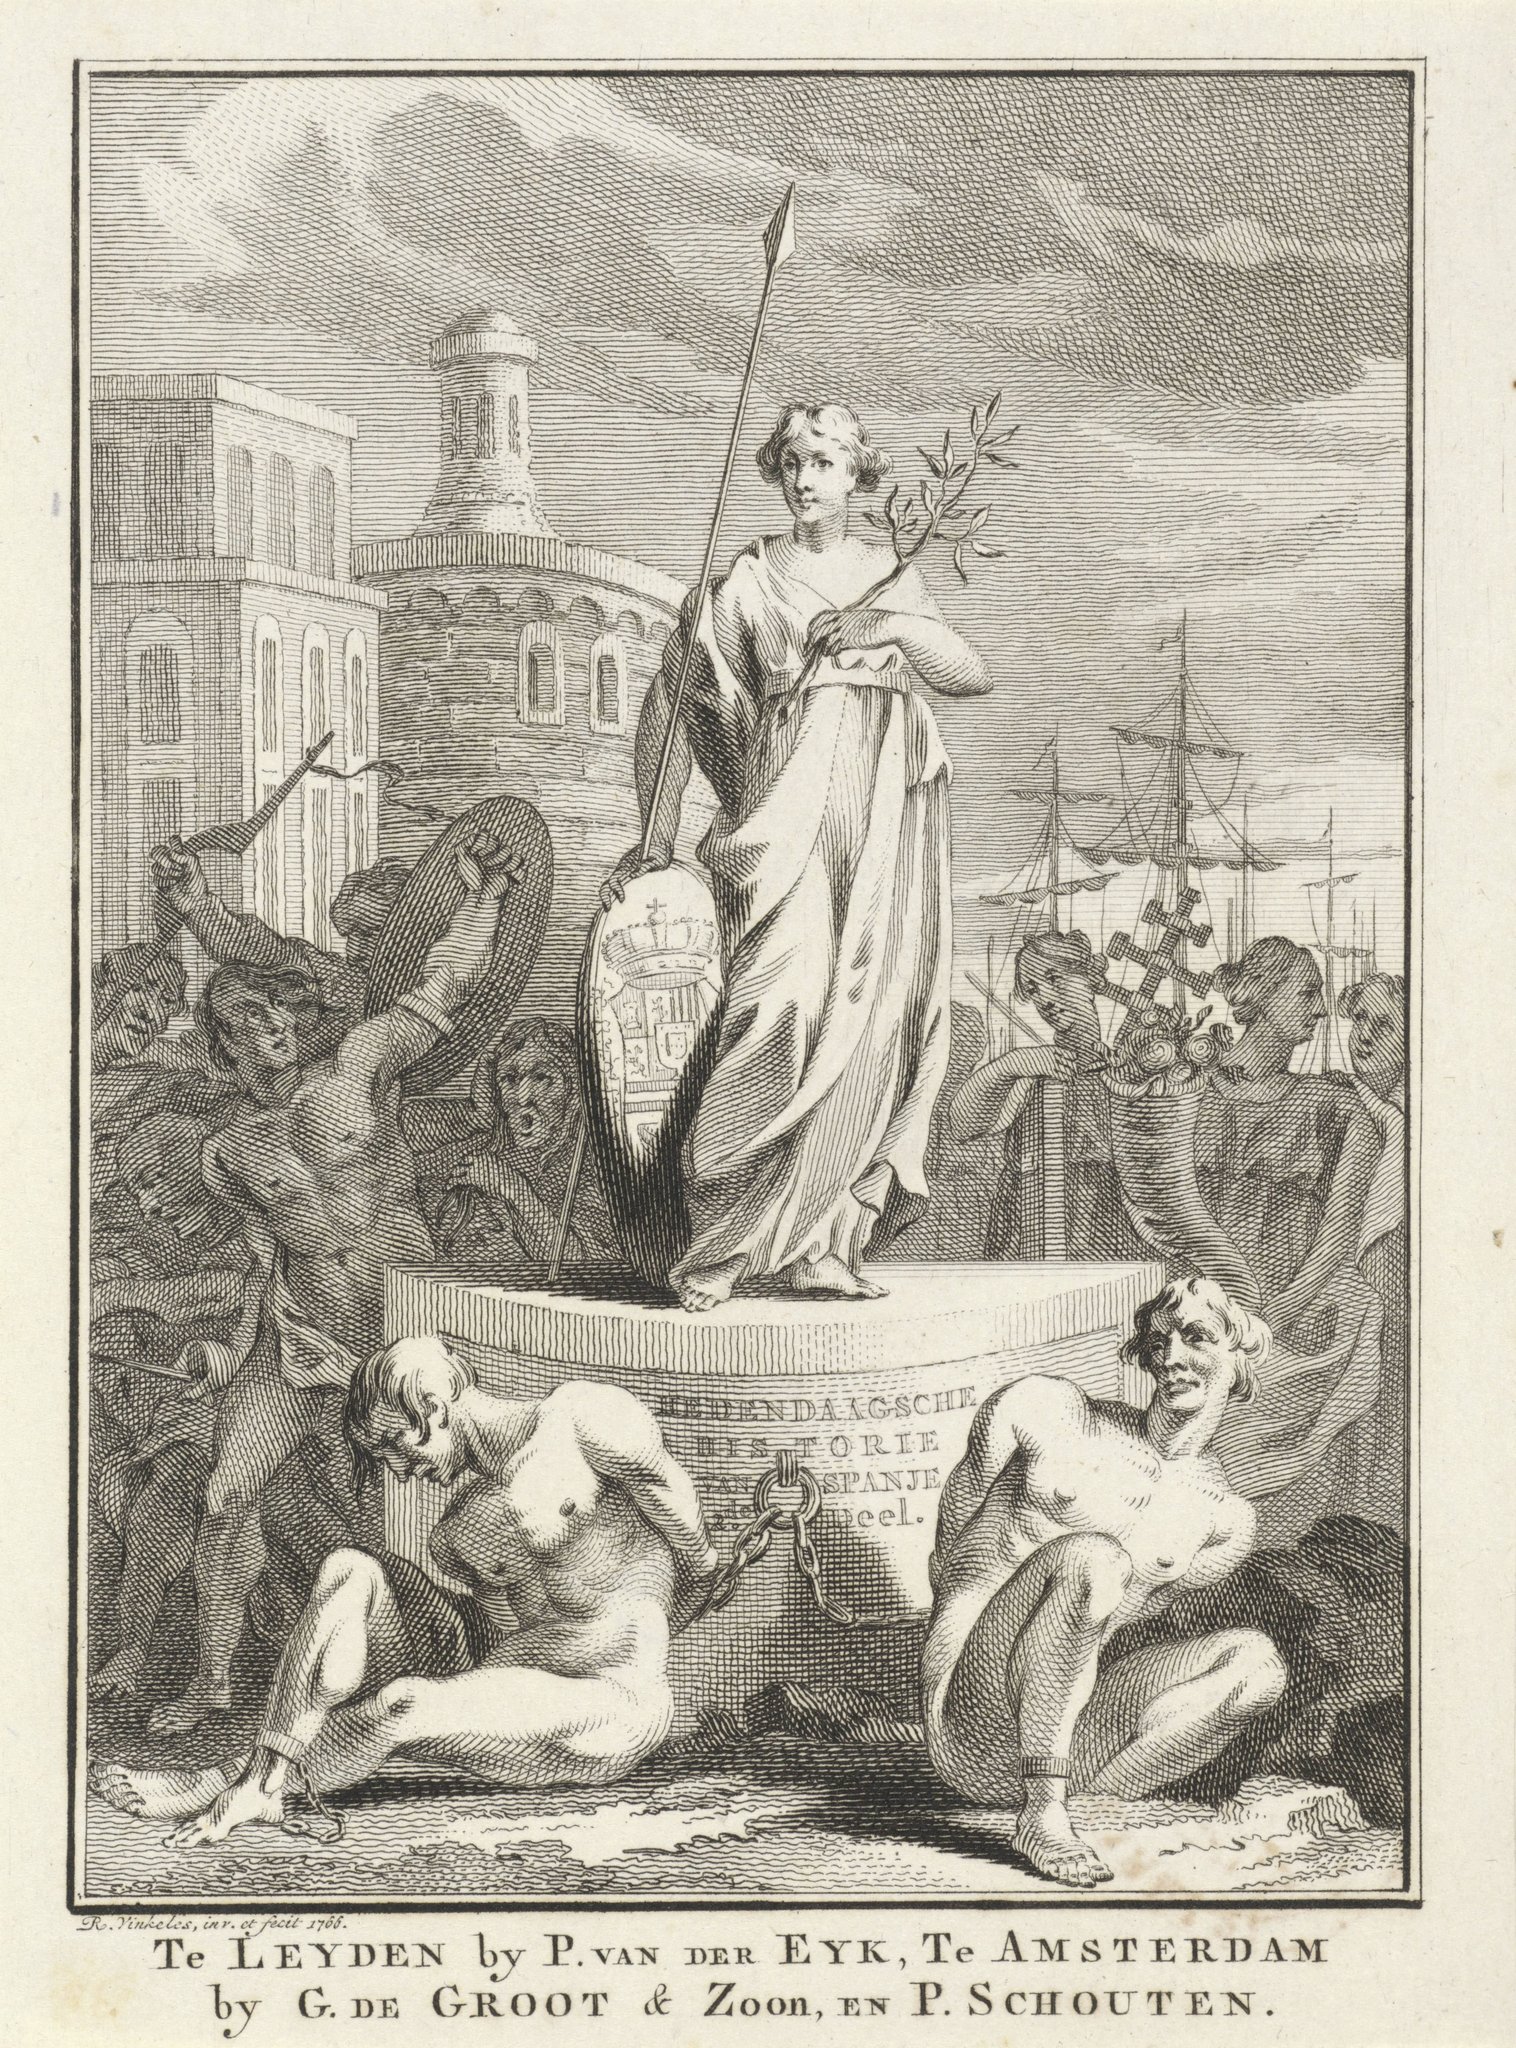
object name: titelblad, titelpagina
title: Titelpagina voor: 'Hedendaagsche Historie der Spanjaarden, deel 2', 1765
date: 1765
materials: paper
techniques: engraving, etching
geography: leiden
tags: 'cornucopia', horn of plenty, ships (in general) - cc - more than one ship, pax as roman personification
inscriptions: collector's mark: Lugt 240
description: Titelpagina met een personificatie van Vrede met in de hand een olijftak en een Spaans wapenschild. De personificaties van Geweld en Moord zitten geketend aan haar voetstuk. Op de achtergrond een personificatie van Zeevaart en symbolen van welvaart, zoals de hoorn des overvloeds.